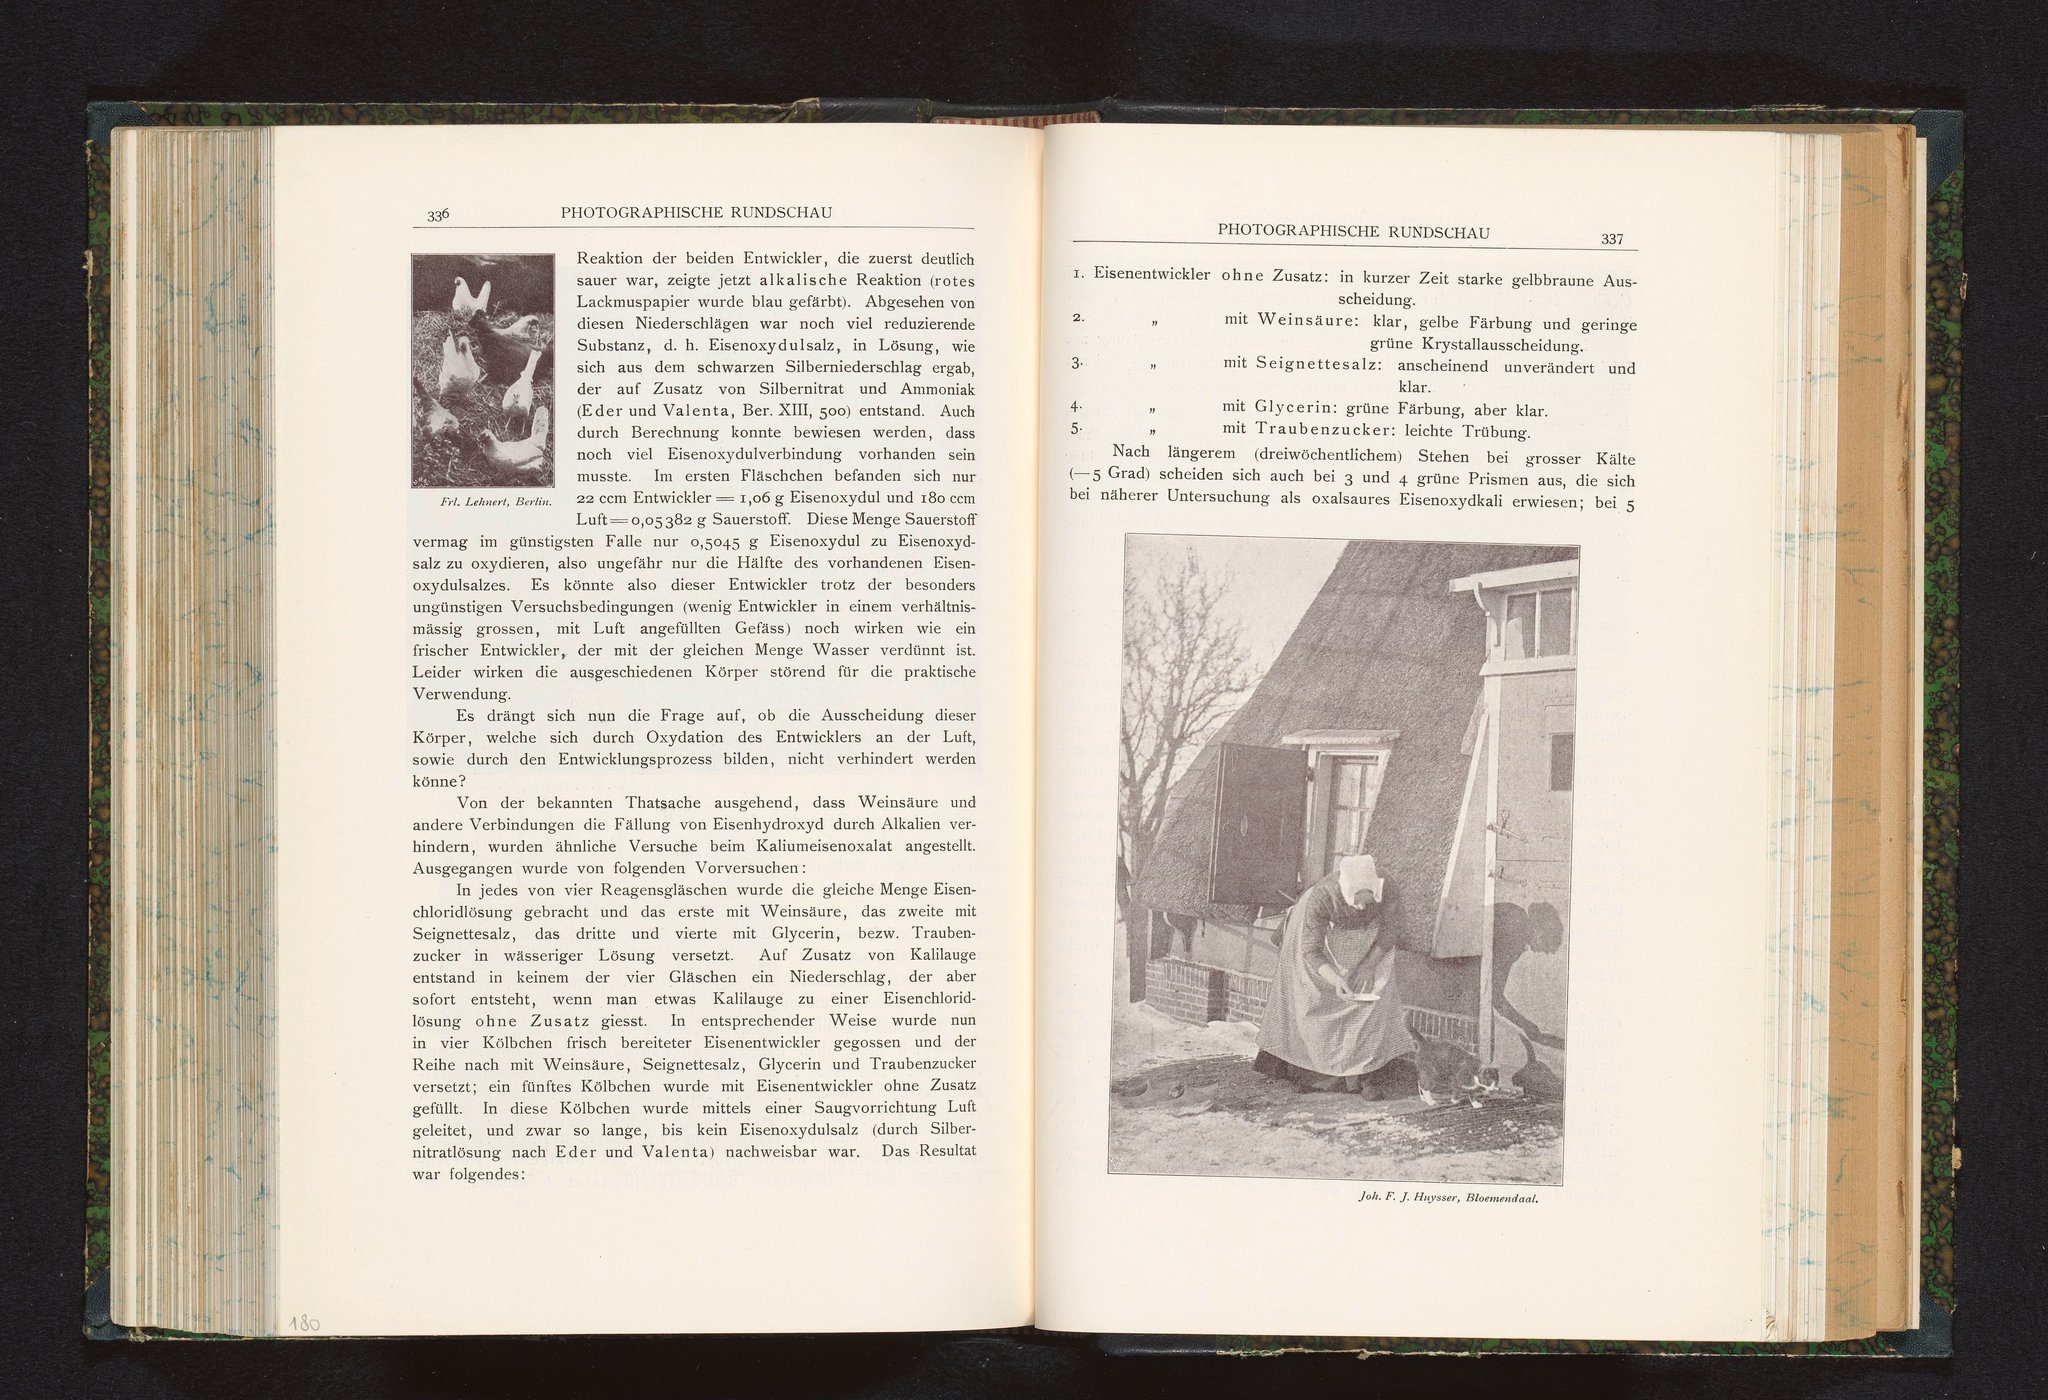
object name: page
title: Vrouw zet een schotel neer voor een kat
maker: johan huijsser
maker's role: fotograaf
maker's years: 1868-1924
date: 1894-1899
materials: paper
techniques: autotype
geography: netherlands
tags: adult woman, cat